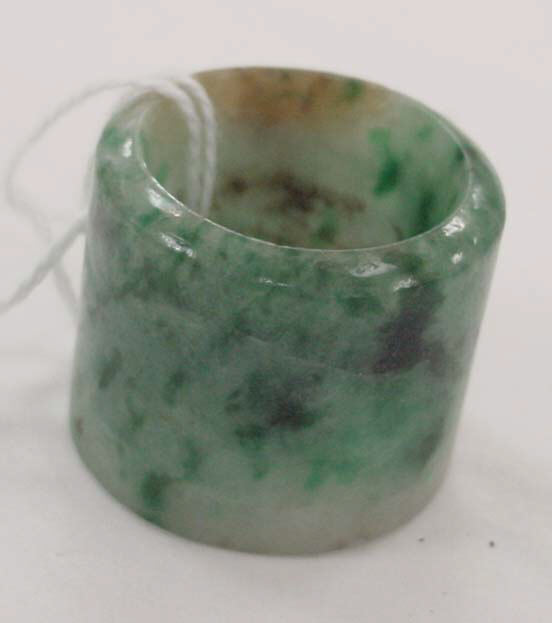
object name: ring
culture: chinese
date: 1801-1900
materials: jade